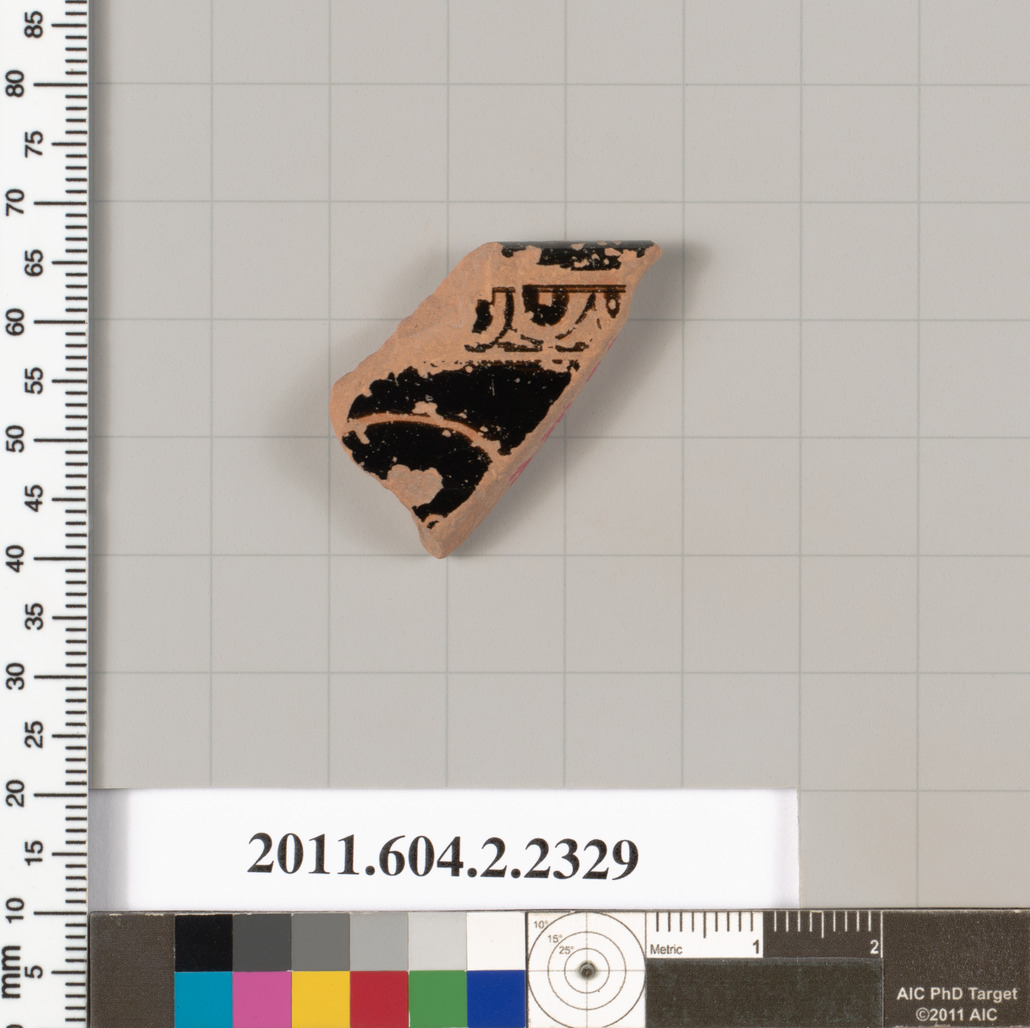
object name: skyphos fragment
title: Terracotta rim fragment of a skyphos (deep drinking cup)?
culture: greek, attic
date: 460-450 BCE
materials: terracotta